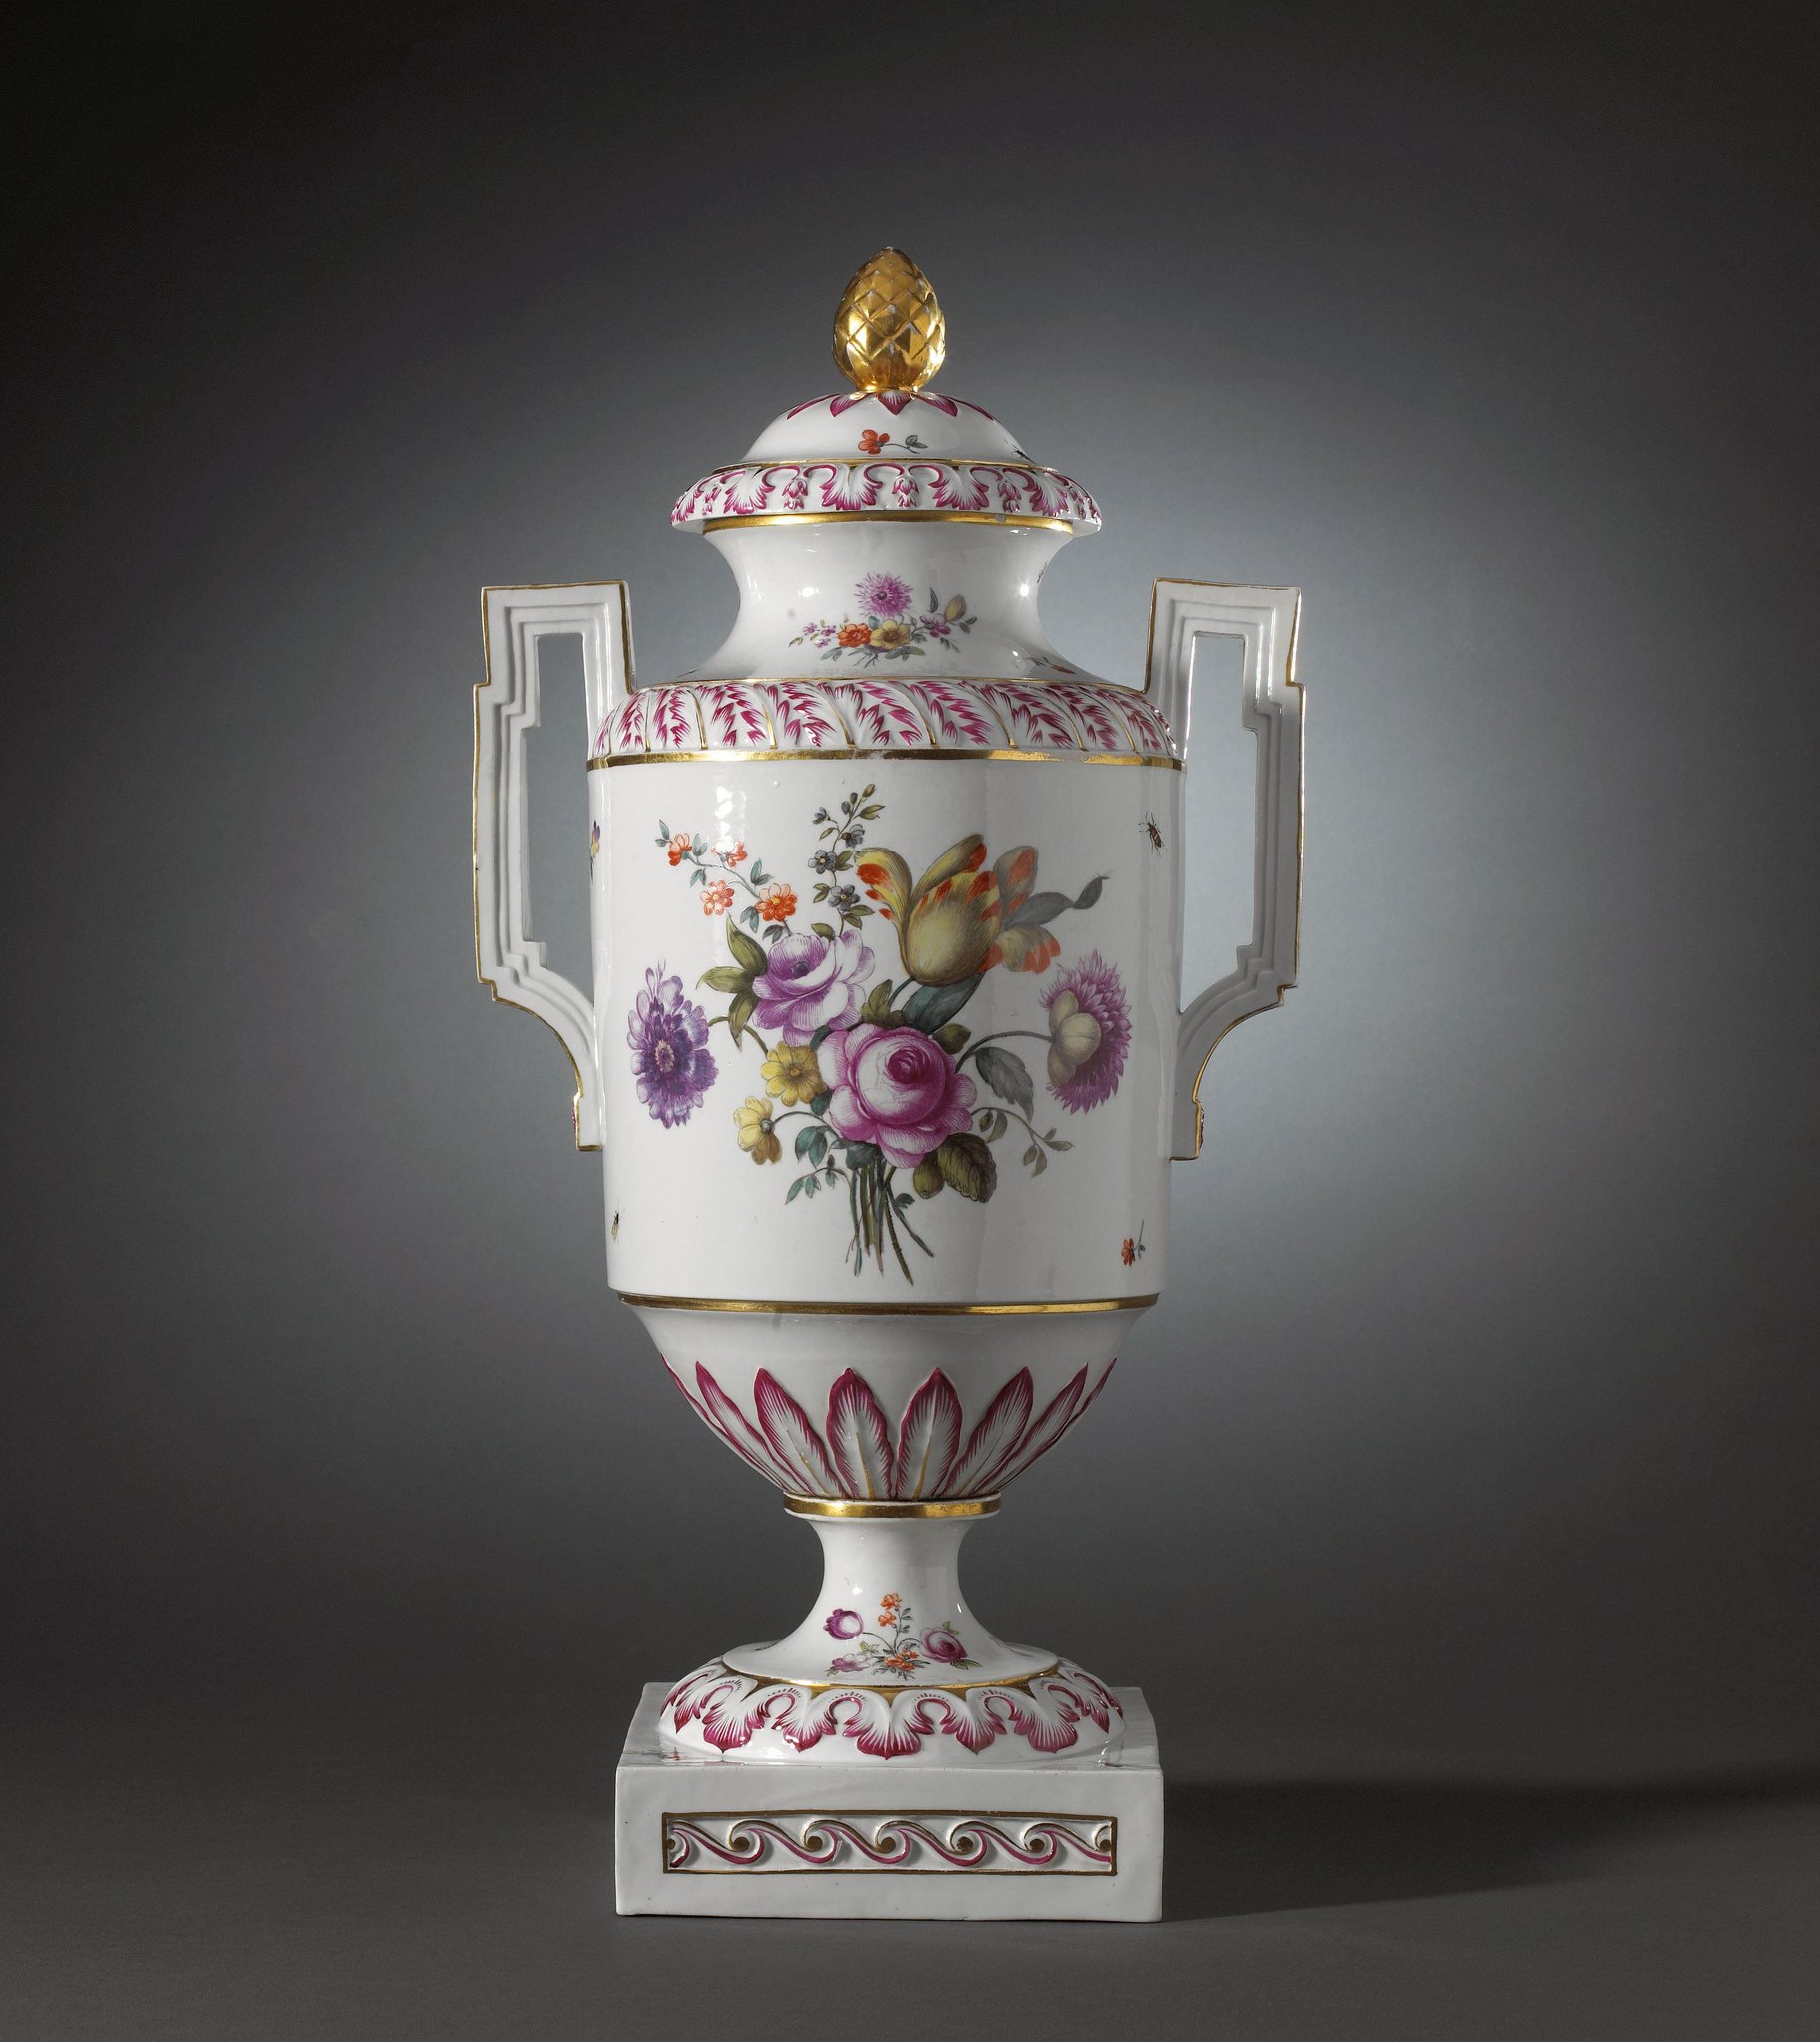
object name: dekselvaas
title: Covered vase with birds on a branch and bouquets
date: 1785-1790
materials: glaze, gold, paint, porcelain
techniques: firing, forming, gilding, relief, turning, vitrification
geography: furstenberg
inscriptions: mark: ‘F/ A.F.’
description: Dekselvaas van porselein op een spreidende voet eindigend in een vierkant voetstuk en met een cilindrisch lichaam met ronde schouder en zich vernauwend naar de voet. Spreidende nek met een platte rand en hoge, hoekige oren. Beschilderd op het glazuur in blauw, rood, roze, groen, geel, paars, zwart en goud. Op de buik twee vogels op een tak in een landschap en een boeket van verschillende bloemen. Hiertussen strooibloemen en insecten. Het vernauwende deel naar de voet met een band met gemodelleerde opstaande bladmotieven in reliëf. De schouder en de voet met dezelfde decoratie als op de buik met daaronder een band met bladranken in reliëf. Op de hoeken van het voetstuk een bloem of insect. De zijkanten met een krulmotief in bas-reliëf. Gouden rand. Gemerkt op de onderzijde met de F en A.F.